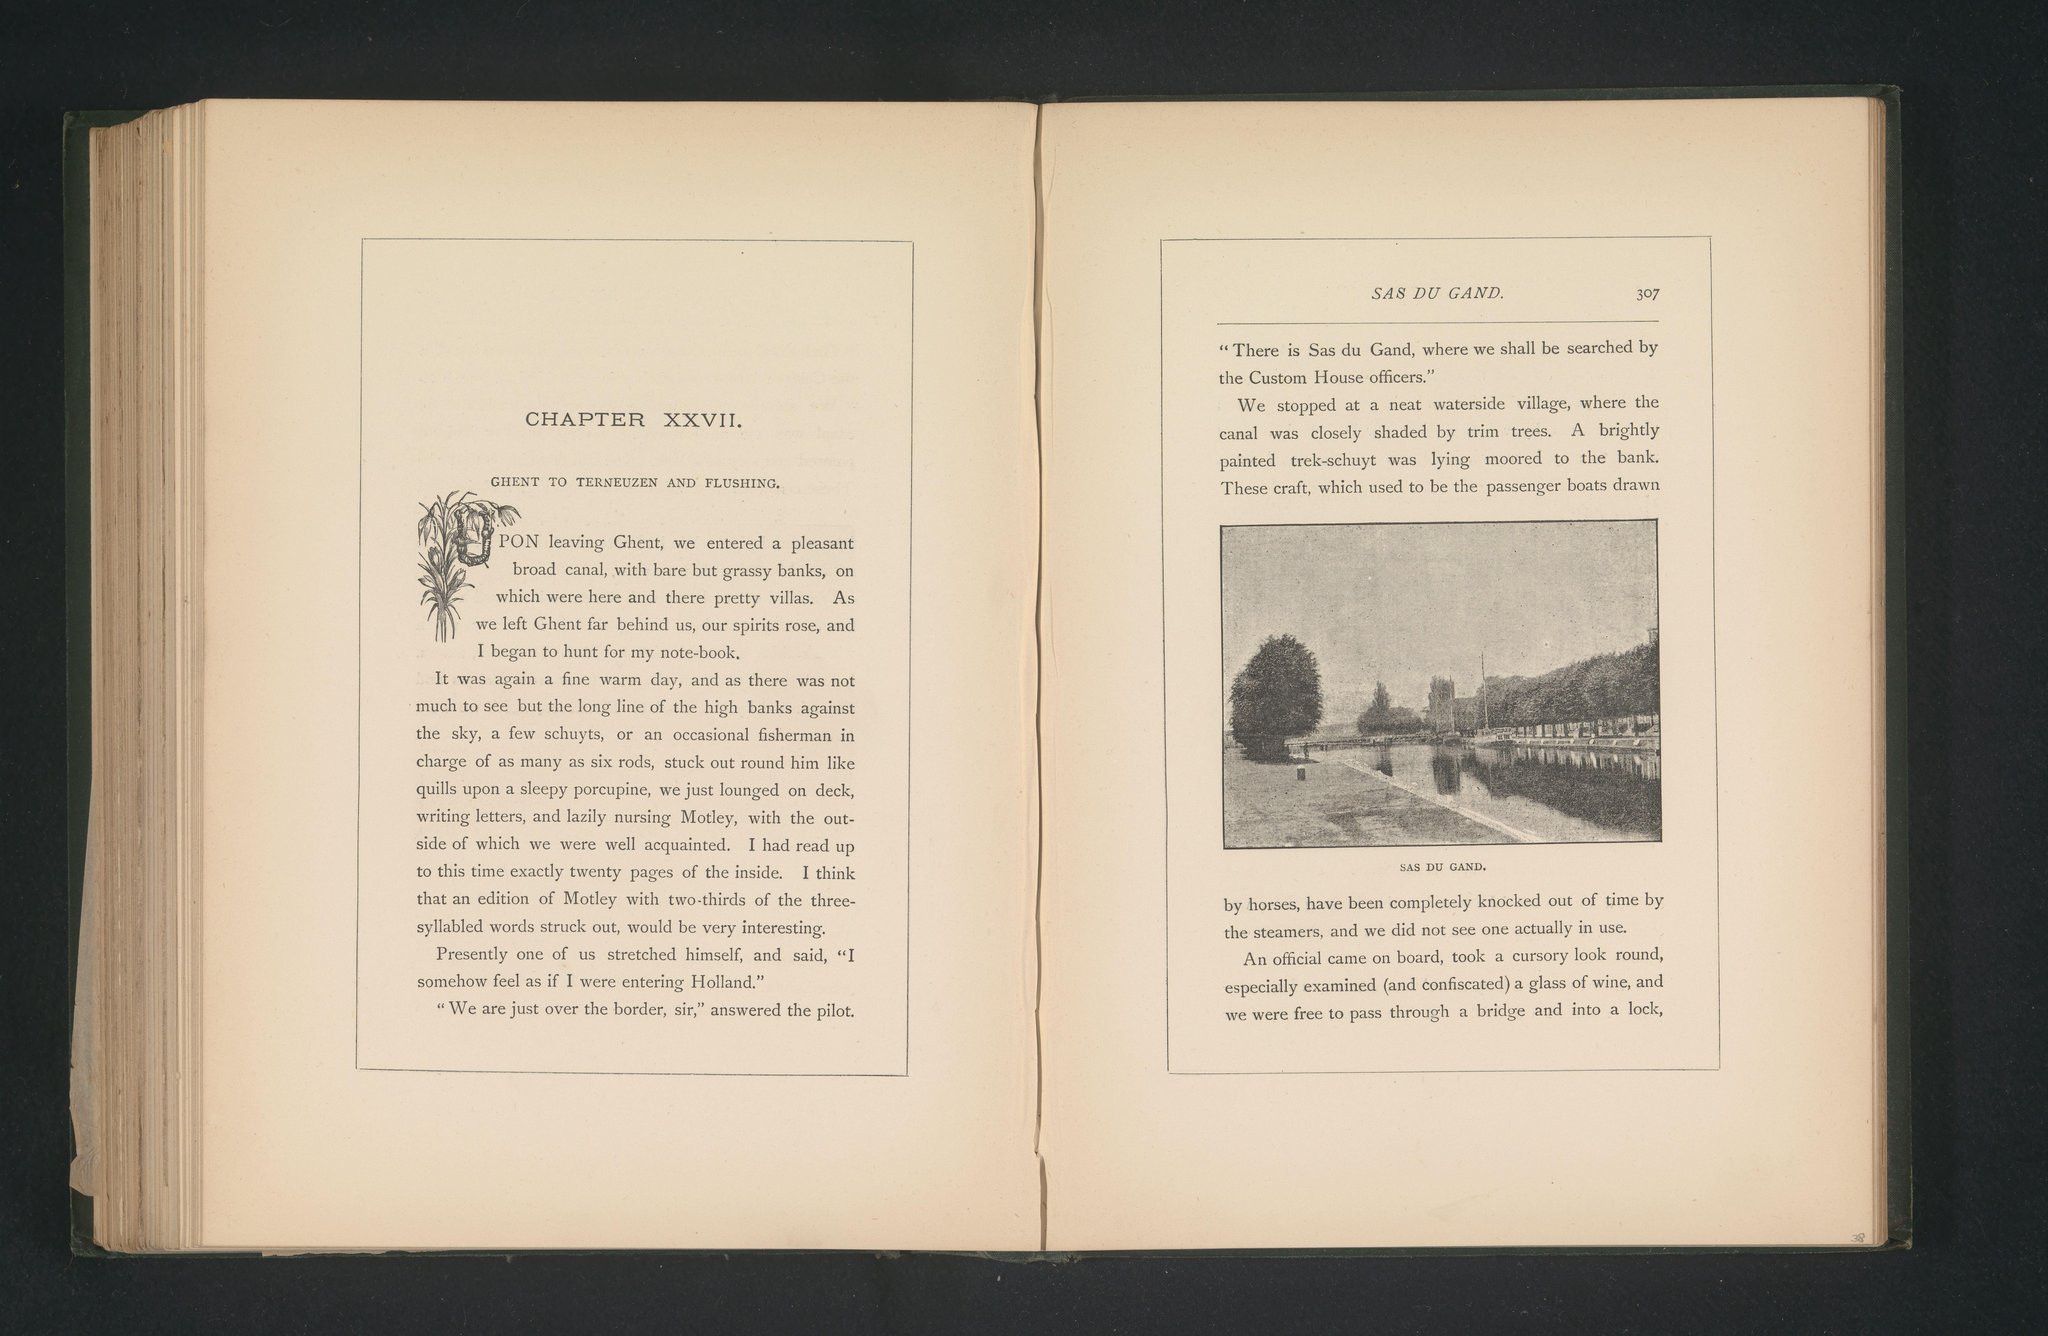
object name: page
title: Gezicht op Sas van Gent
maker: george christopher davies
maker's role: fotograaf, geoloog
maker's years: 1849-1922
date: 1881-1886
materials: paper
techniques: autotype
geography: sas van gent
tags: prospect of village, silhouette of village